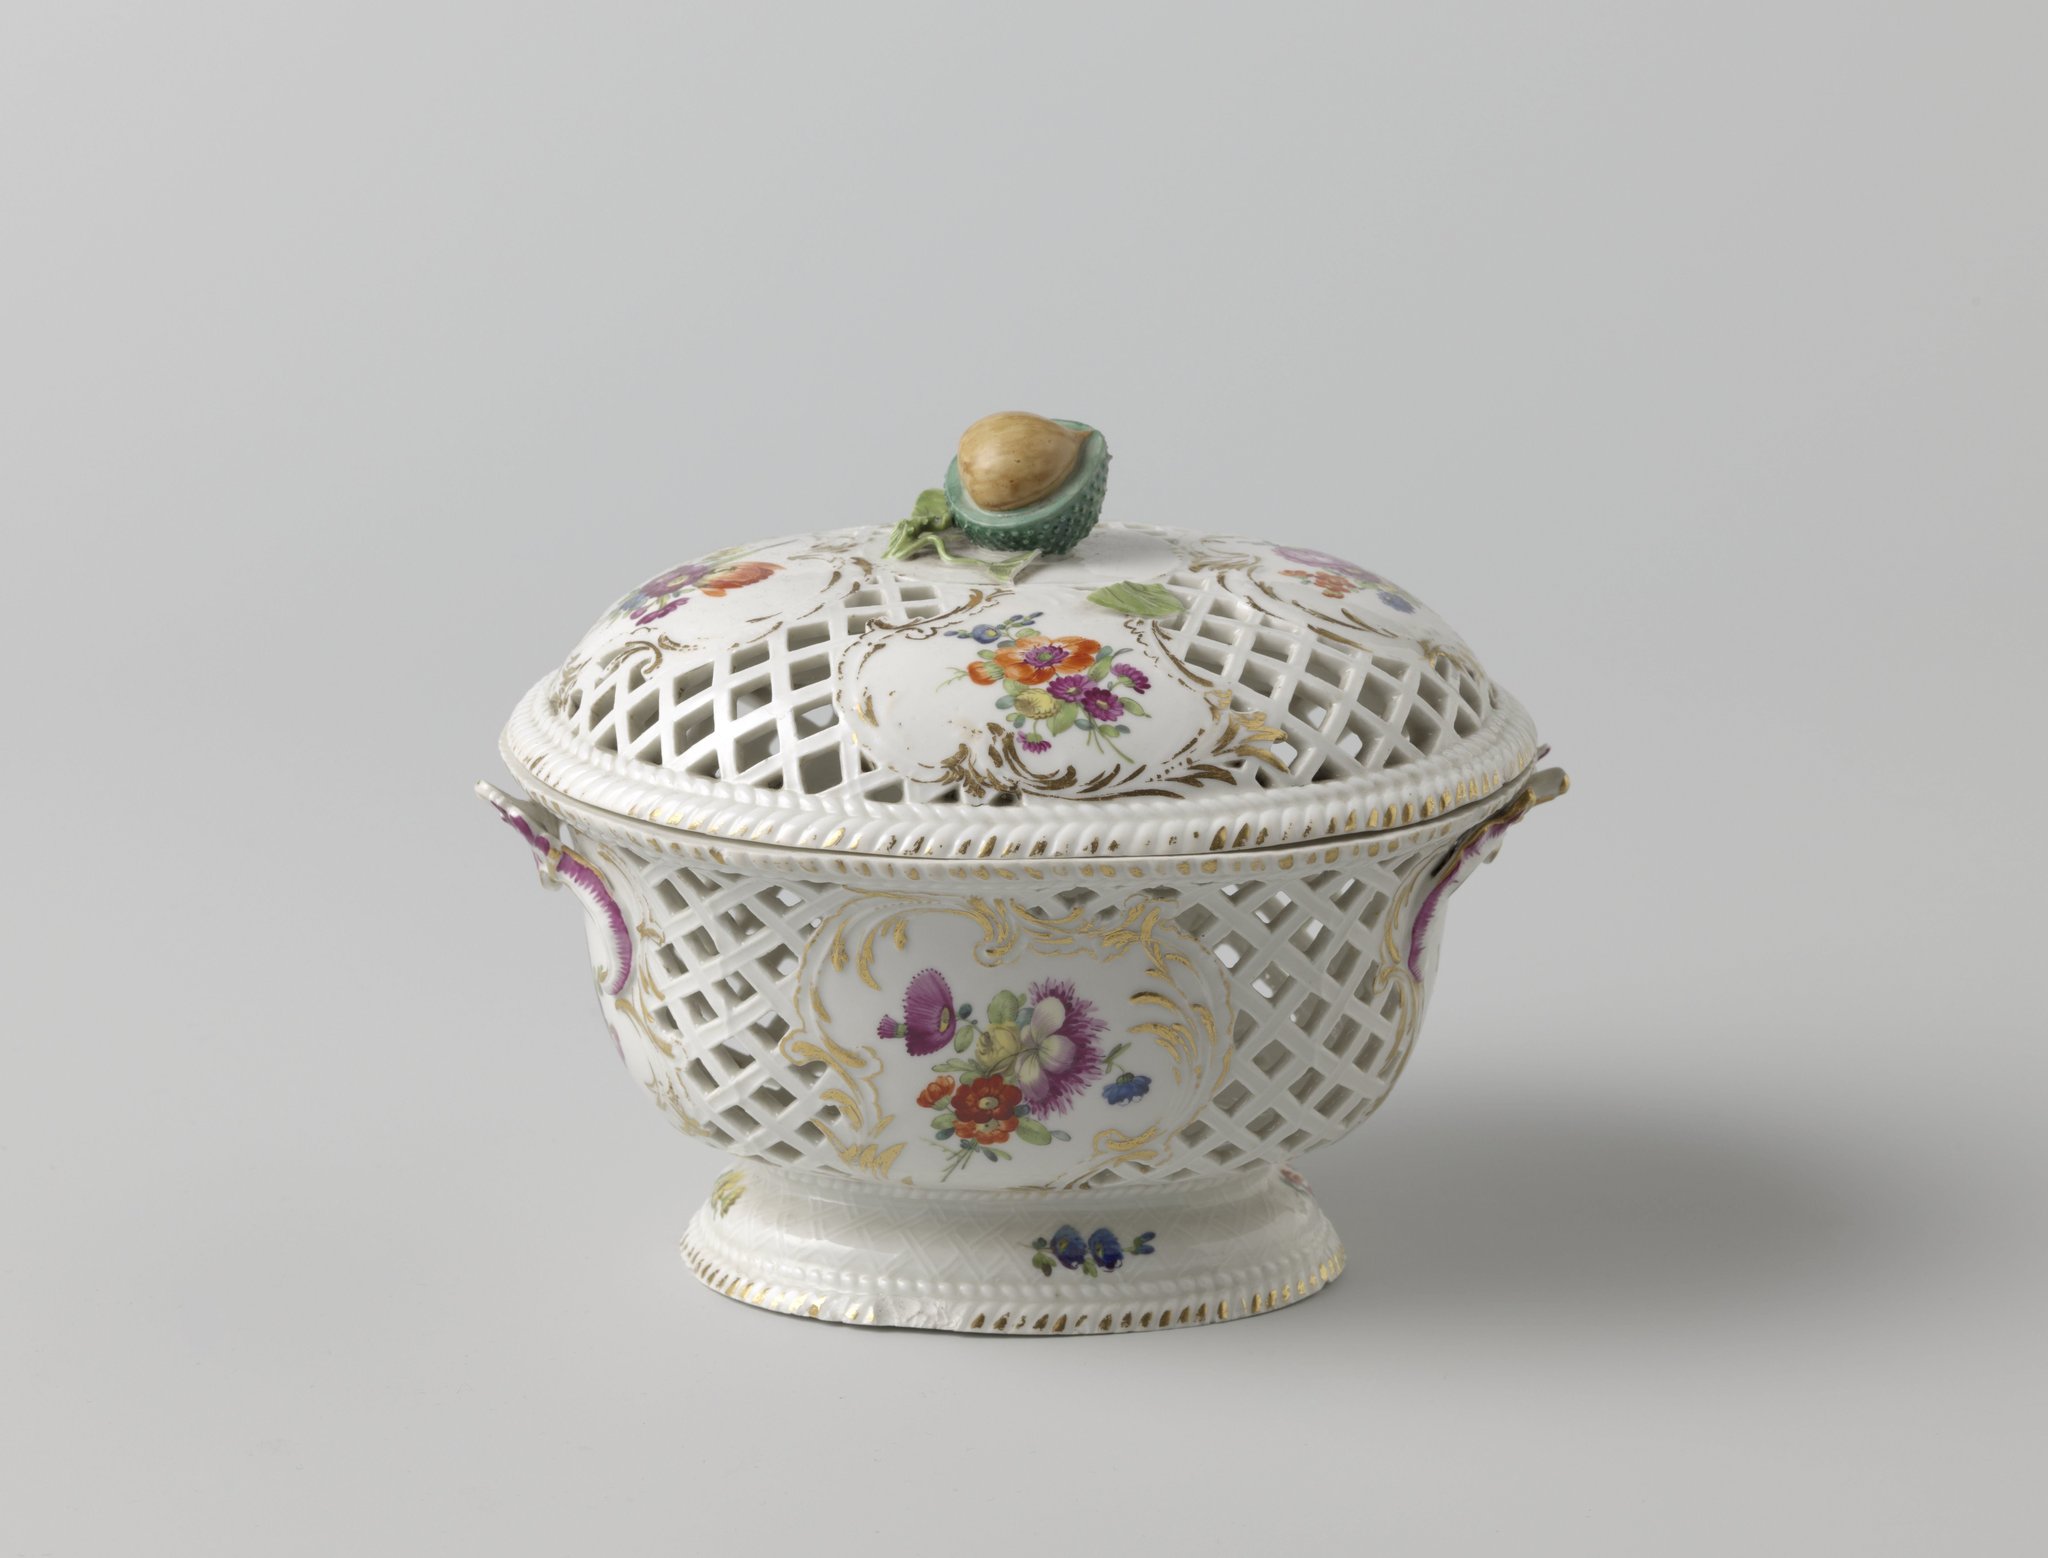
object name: tureen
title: Terrine met deksel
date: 1780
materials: porcelain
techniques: painted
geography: the hague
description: Walnut basket with cover. Porcelain. Fürstenberg (?)( Germany), decorated in The Hague, c. 1777 - 1790. Factory of Anton Lyncker or his heirs.